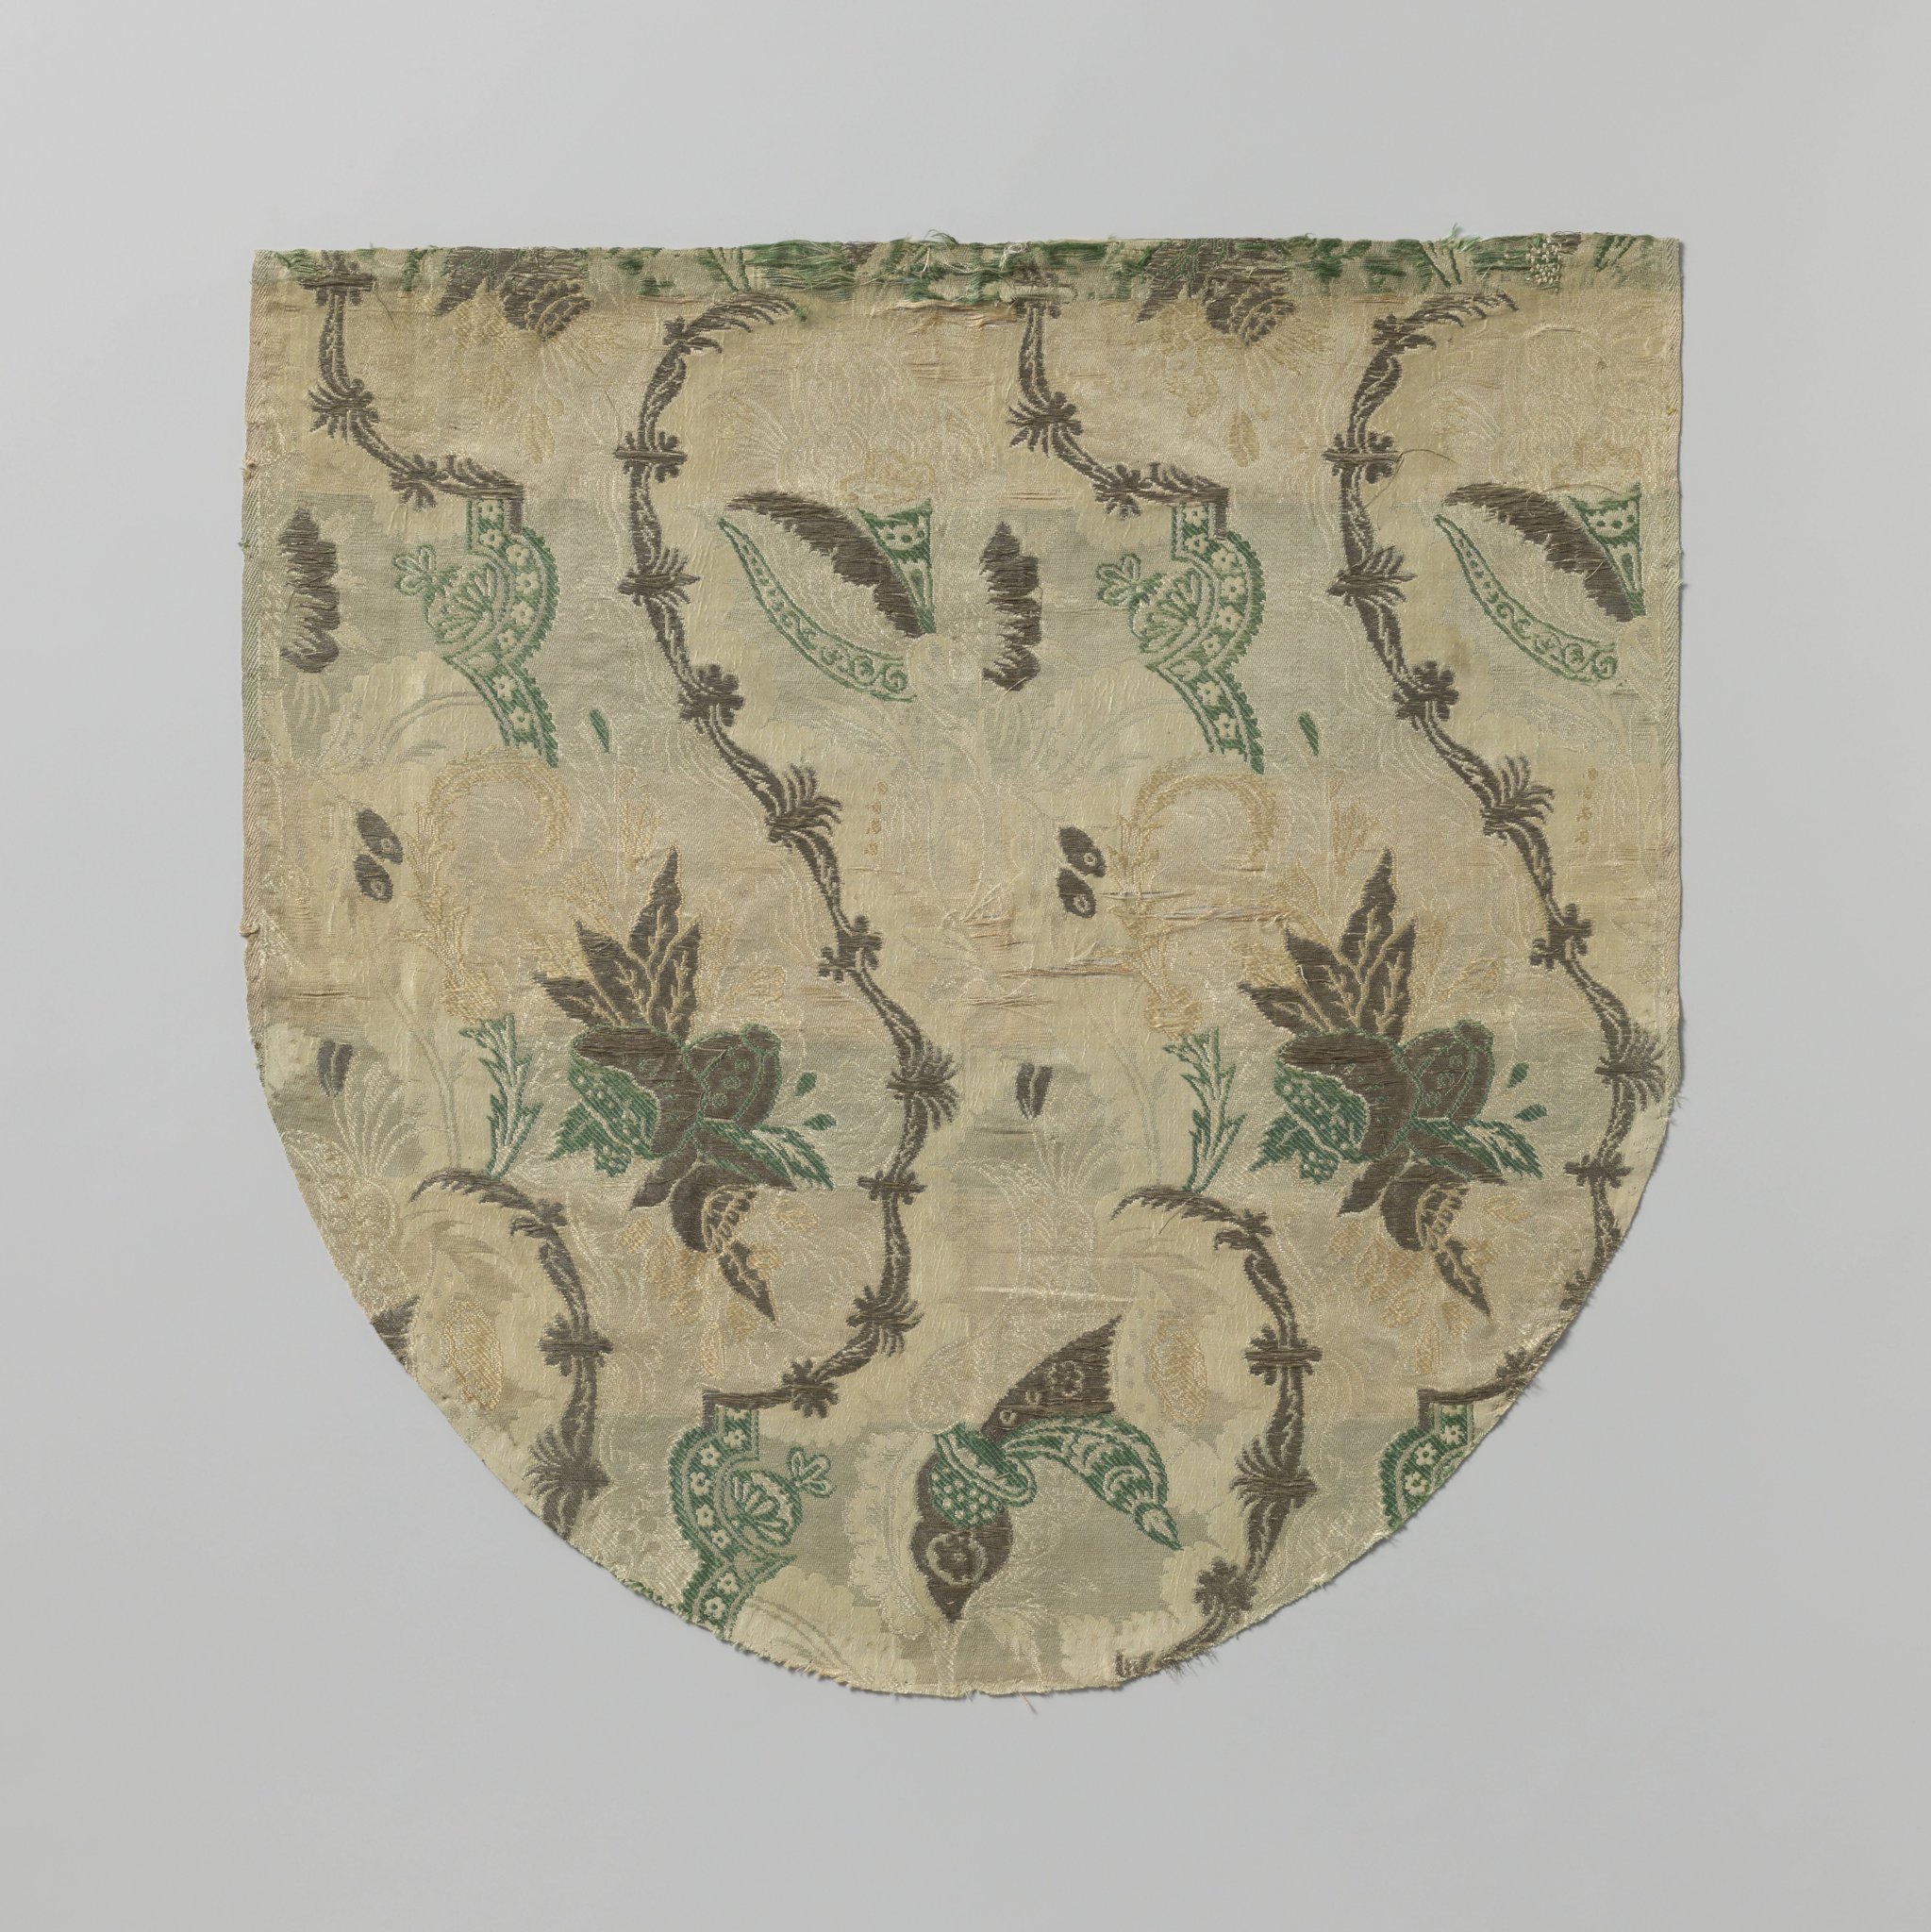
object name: cope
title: Rugschild van een koorkap, van zijde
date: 1700-1750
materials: silk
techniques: brocade, lampas, weave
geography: lyon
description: Rugschild van een koorkap, van zijdeweefsel. Het patroon heeft zilveren ranken en boeketten met zilveren en groene bladeren op een beige gewerkte grond. Opmerking: Identiek aan BK-NM-1234, cat 206.